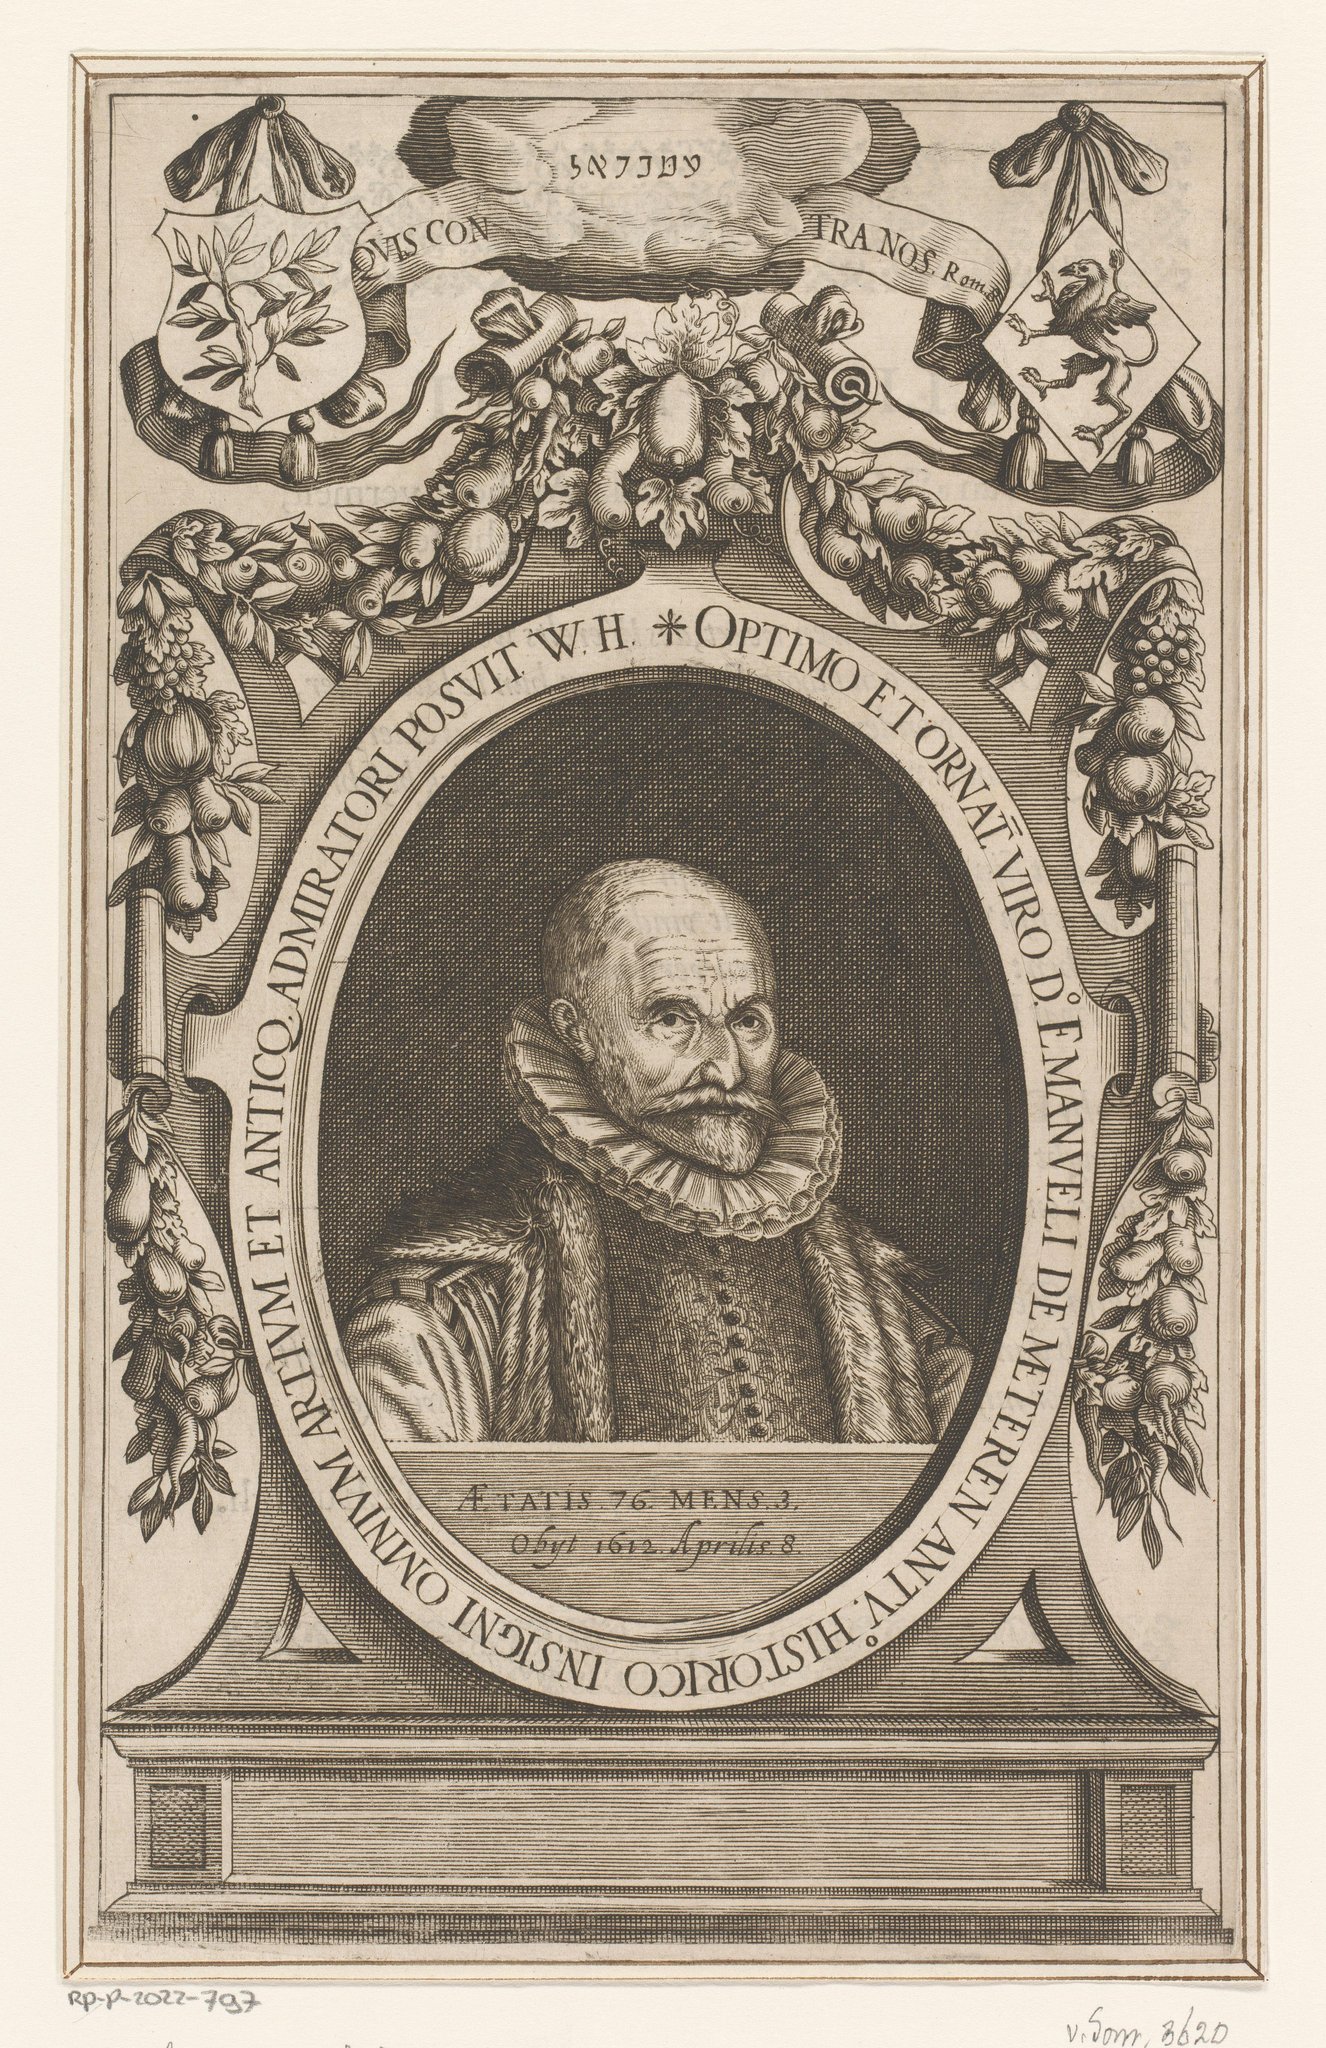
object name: print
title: Portret van Emanuel van Meteren op 76-jarige leeftijd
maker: Anonymous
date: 1614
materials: paper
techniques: engraving, letterpress printing, snipping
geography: the hague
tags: antwerp, london, emanuel van meteren, historical persons, portrait of a writer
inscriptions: collector's mark: Lugt 2228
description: Prent uit: Meteren, Emanuel van. Emanuels van Meteren Historie der Neder-landscher ende haerder na-buren oorlogen ende geschiedenissen, tot den jare 1612 (...). Den Haag: weduwe en erfgenamen Hillebrant Jacobsz. van Wouw, 1614.